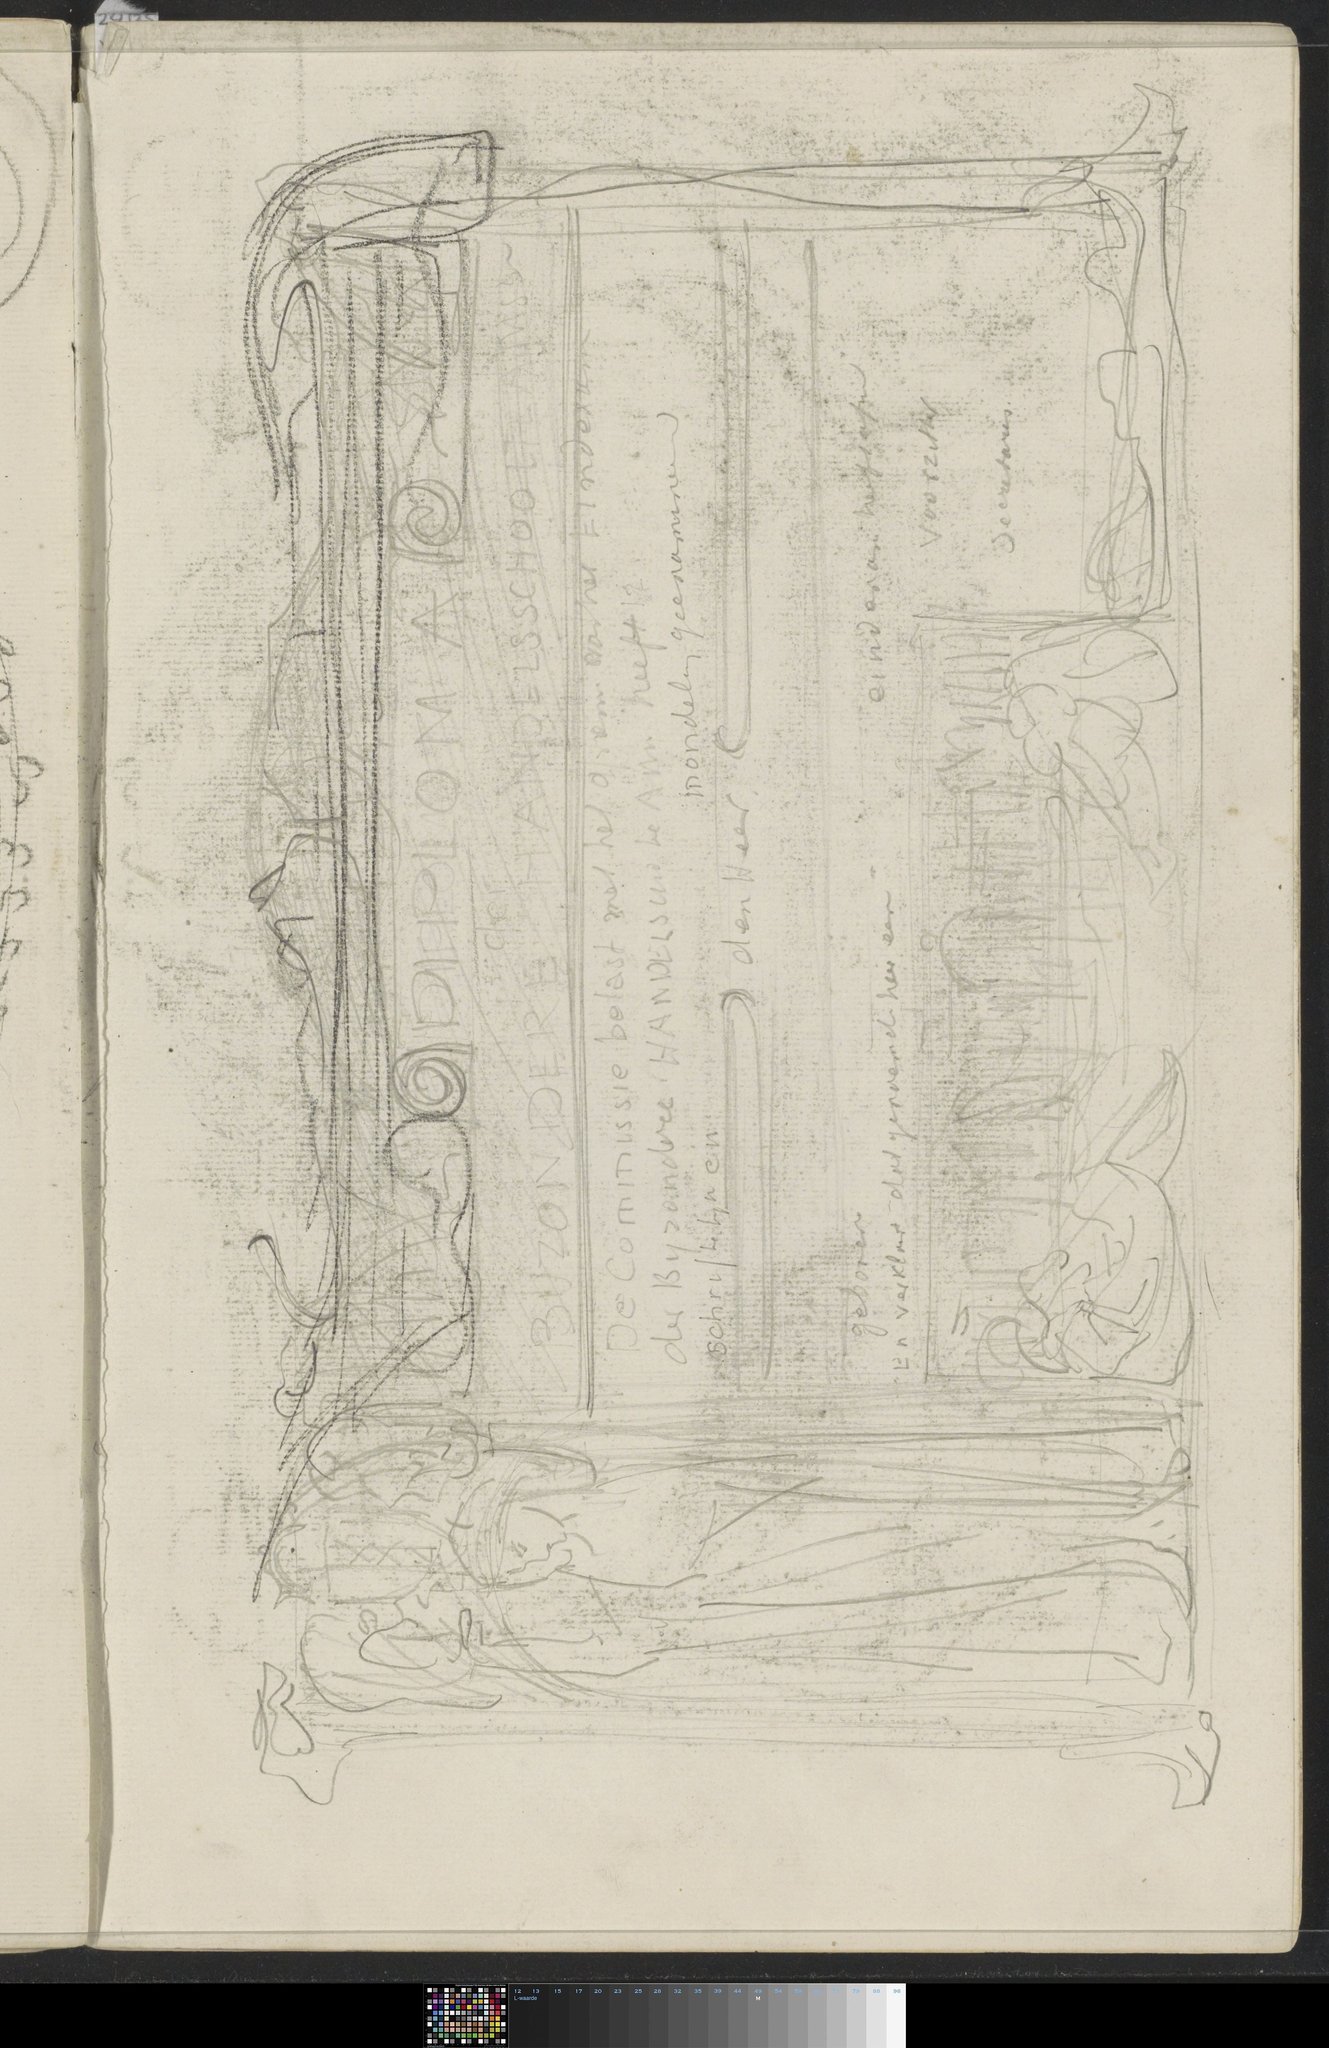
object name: sketchbook leaf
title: Ontwerp voor een diploma voor de Bijzondere Handelsschool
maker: carel adolph lion cachet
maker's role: draughtsman, print maker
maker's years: 1864-1945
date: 1897-1898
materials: chalk, paper, pencil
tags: printed matter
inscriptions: annotation: ‘DIPLOMA/ BIJZONDERE HANDELSSCHOOL/ De Commissie belast met het afnemen van het Eindexamen/ der Bijzondere Handelschool te AM heeft/ schriftelijk den Heer mondeling geexamineerd/ geboren/ verklare dat genoemde heer een eindexamen geeft afm[...]/ voorzitter/ secretaris’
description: Blad 24 recto uit een schetsboek met 29 bladen.